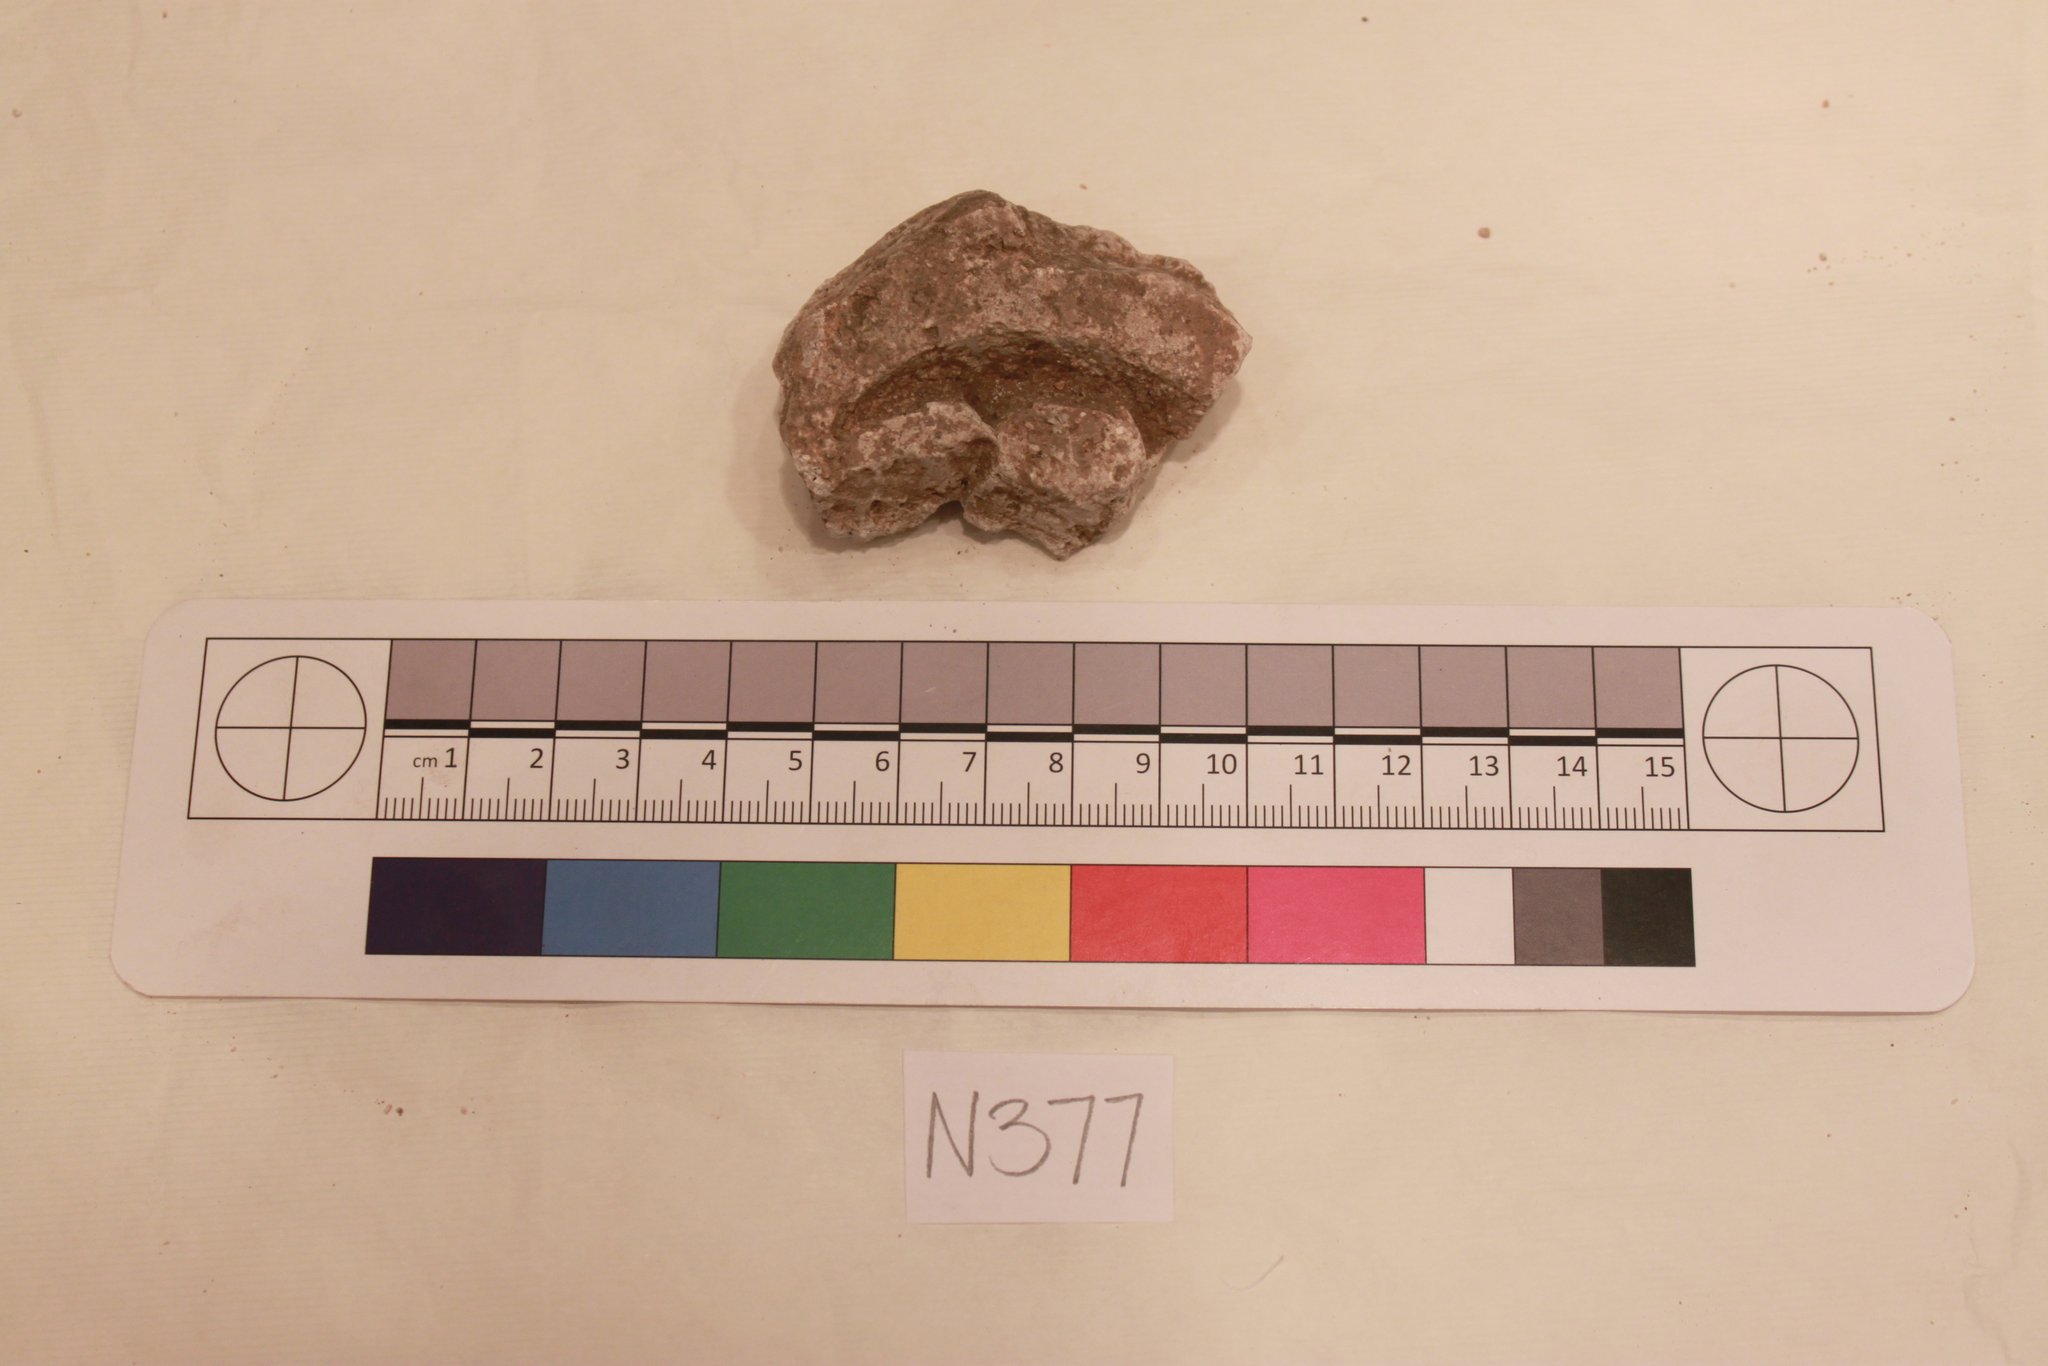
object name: fragment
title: Stucco Fragment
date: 701-1200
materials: plaster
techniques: carving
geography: iran